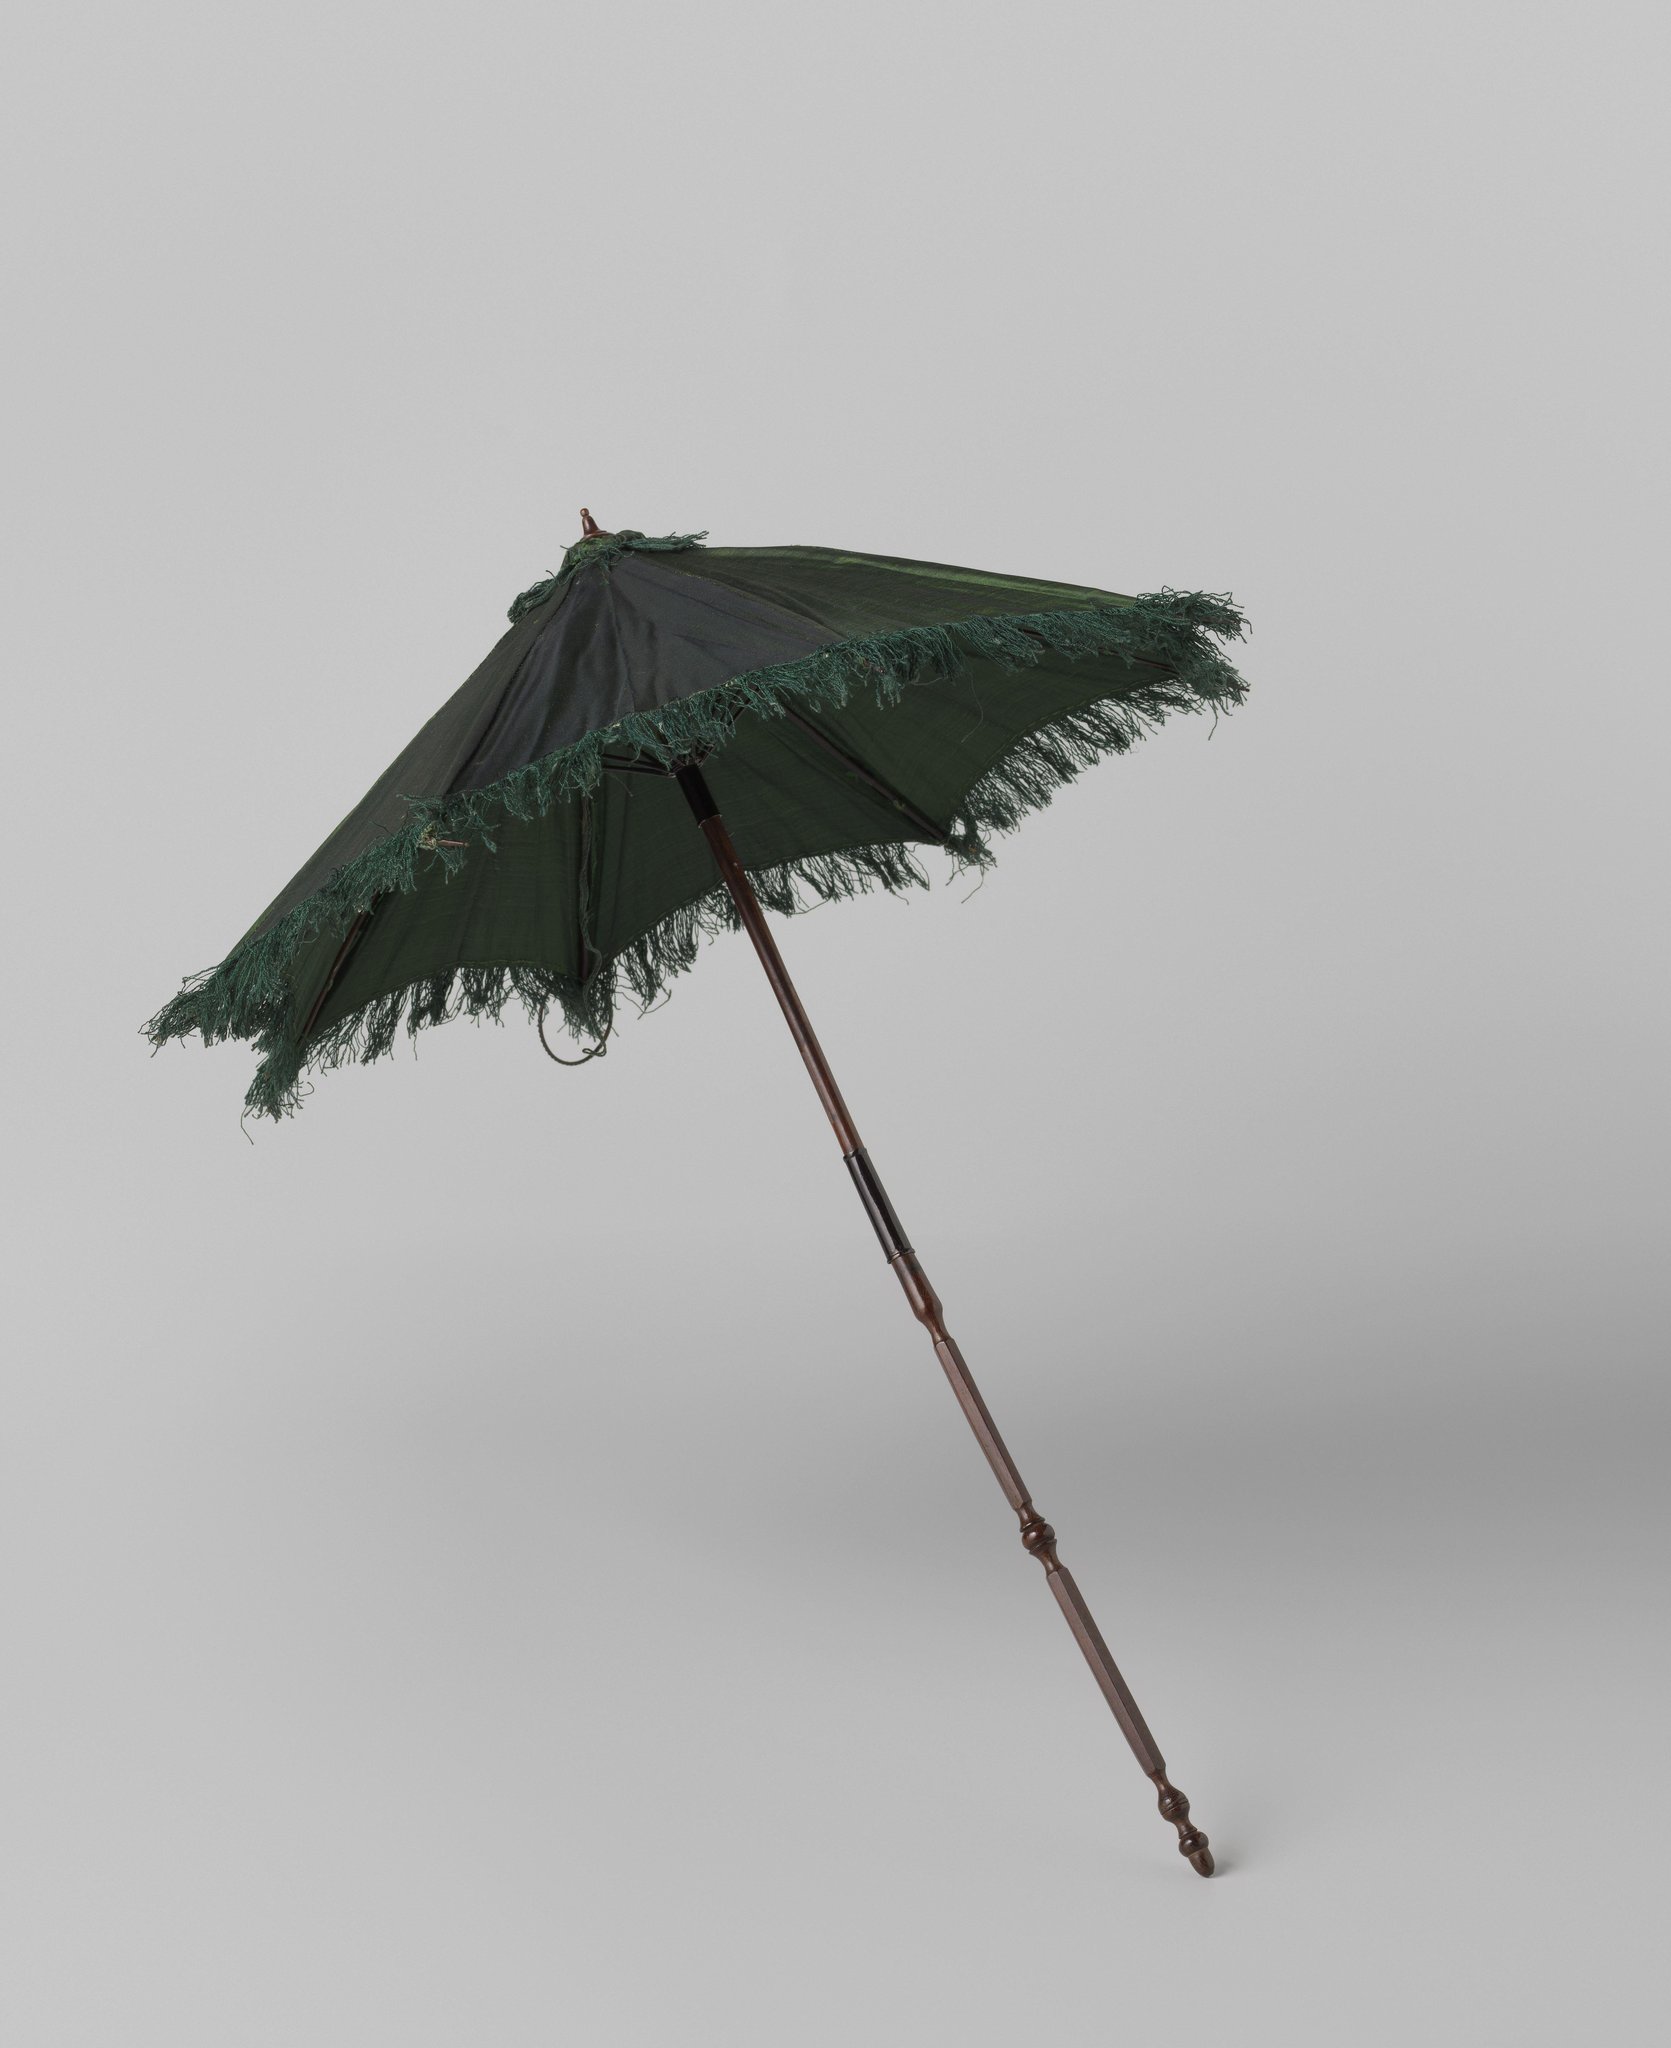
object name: parasol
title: Parasol met dek van groene changeant zijde en lange gesneden palissanderhouten scharnierende stok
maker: Anonymous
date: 1800-1899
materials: baleen, metal, wood, silk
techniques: casting, cutting, weave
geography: france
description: Parasol met dek van groene changeant zijde, met bovenop en langs de rand een franje. Het dek is ongevoerd en telt zeven walvisbaleinen. Langs het dek een dubbel groen koord met een metalen ring die over het dek geschoven kan worden, zodat deze gesloten blijft. Lange palissanderhouten stok, gesneden in een zeshoekige vorm, waartussen twee bollen. Halverwege een zwarte metalen schuif, die omhoog geschoven kan worden, waardoor de parasol kan knikken. Nog een tweede knik helemaal bovein de parasol. Bovenop een kleine houten knop.